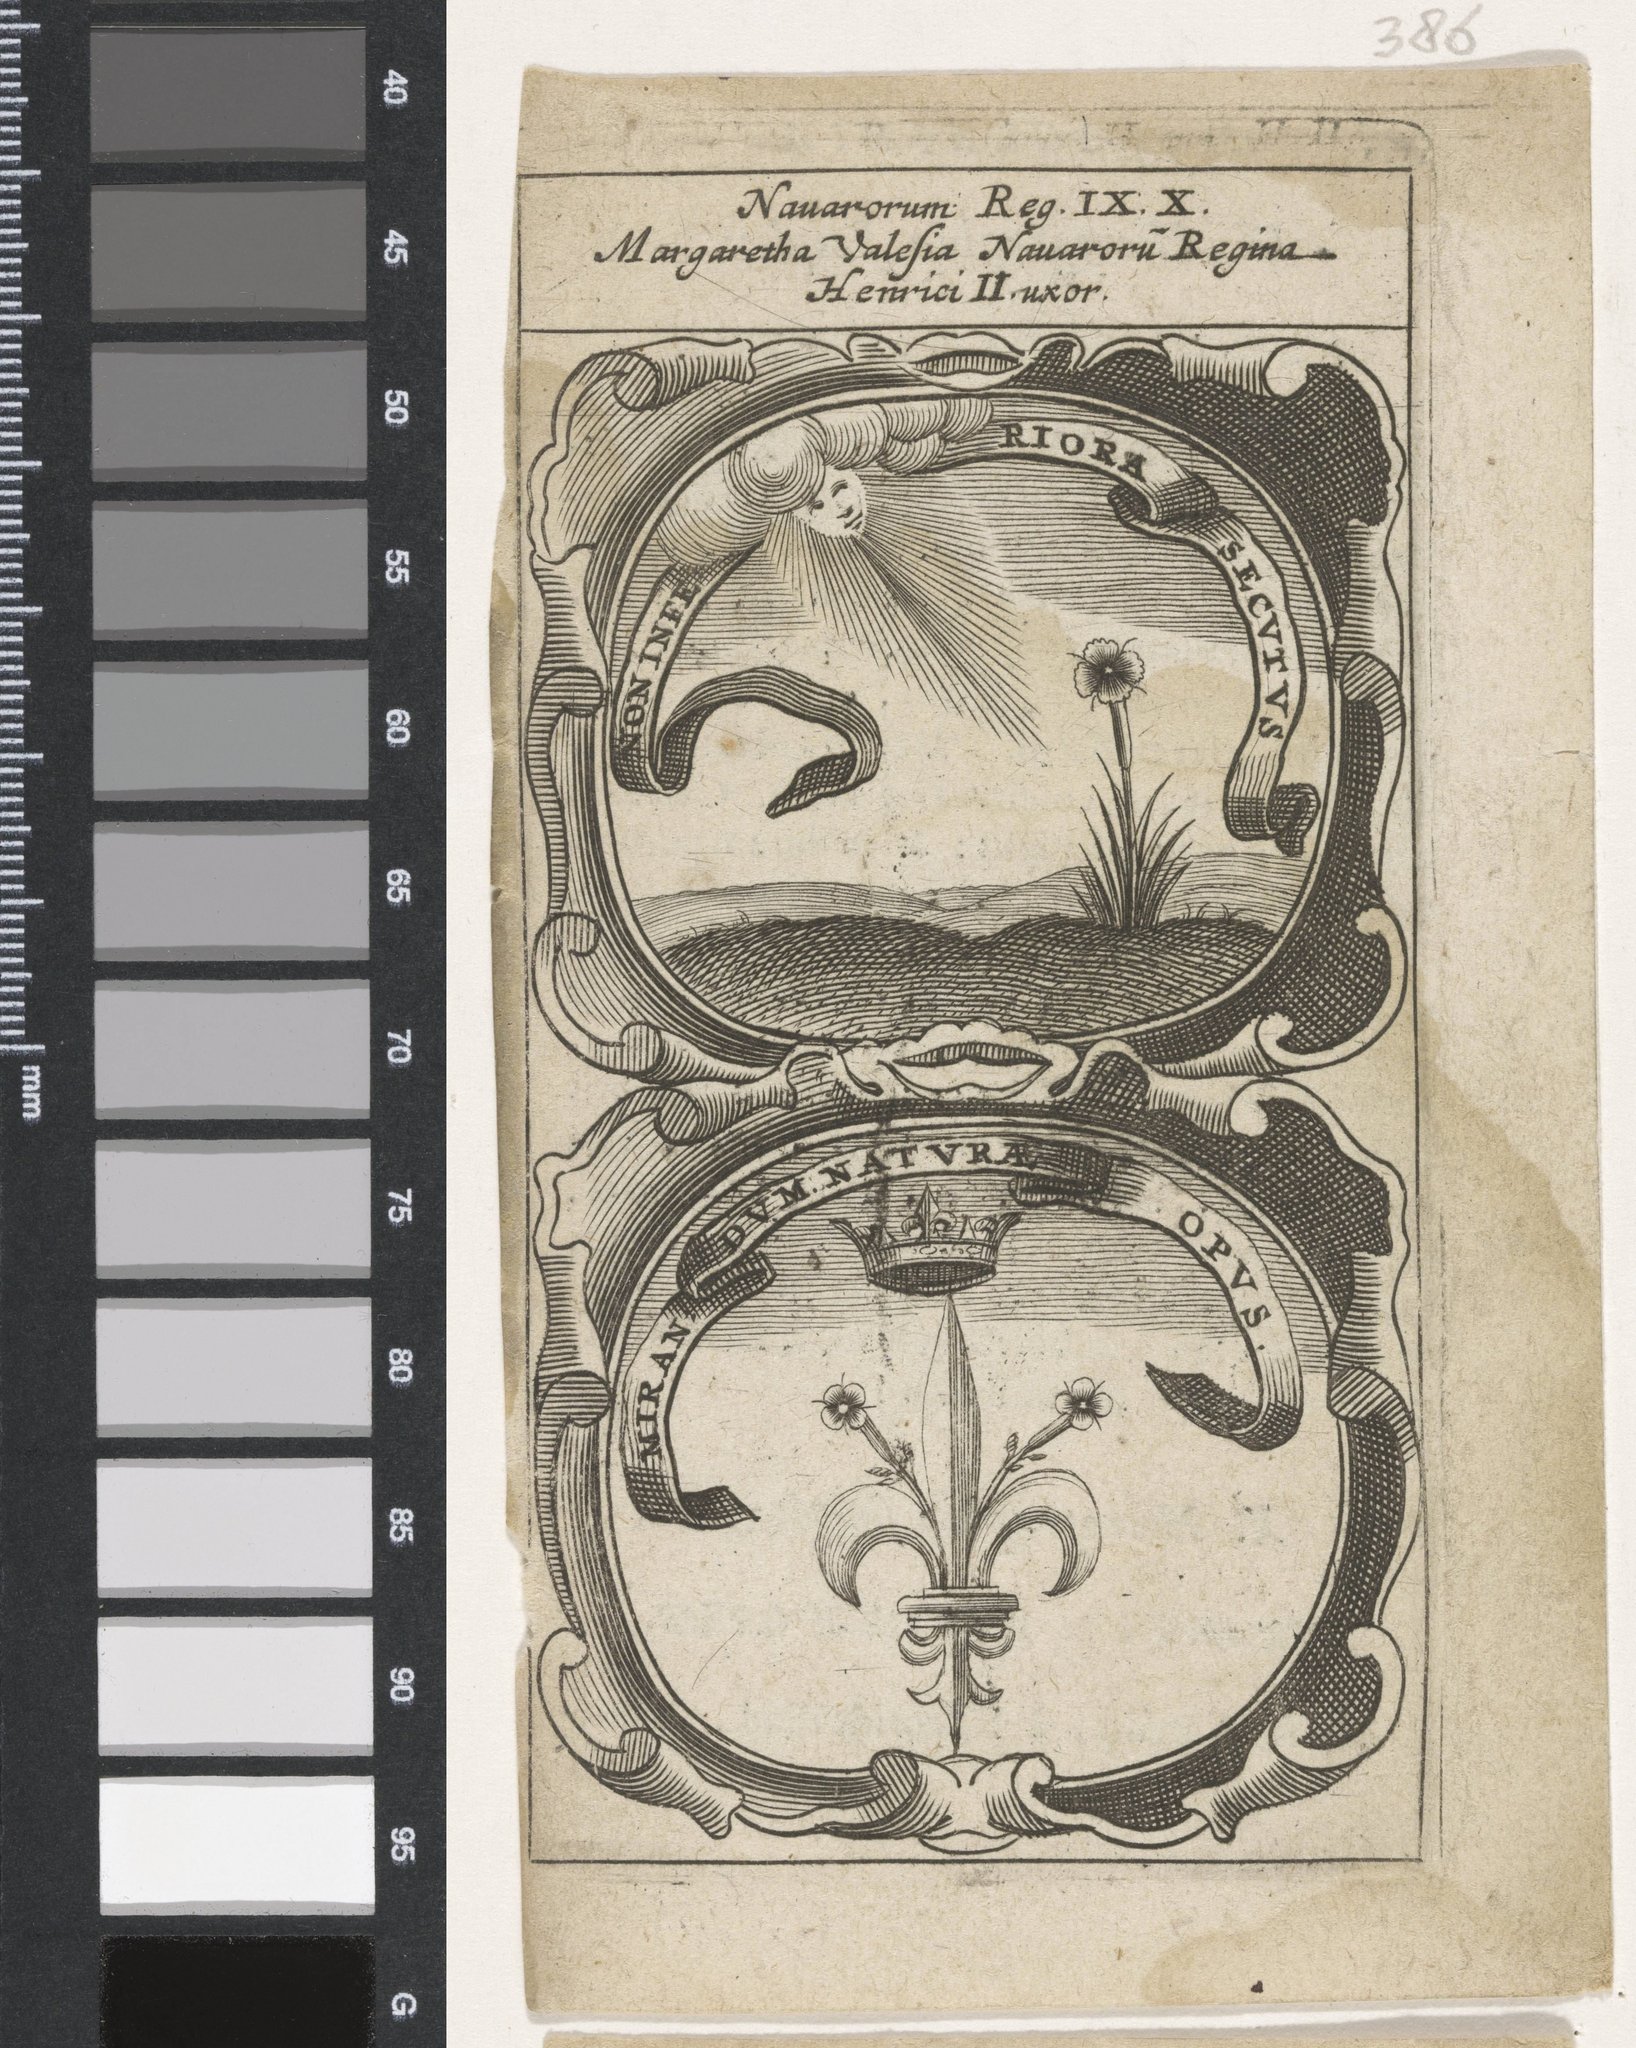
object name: print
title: Bloem beschenen door de zon / Gekroonde Franse lelie met twee bloemen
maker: Anonymous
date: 1666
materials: paper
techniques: engraving, letterpress printing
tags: flowers, fleur-de-lis ~ ornament, sun represented as face, wheel, etc.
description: Pagina uit Jacob Typotius, Symbola Divina & Humana Pontificum Imperatorum Regum. Arnhem, J.F. Hagen, 1666 of uit de titeluitgave van 1669 of 1679. Het werk van Typotius werd voor het eerst uitgegeven in 1601 met prenten van Aegidius Sadeler.